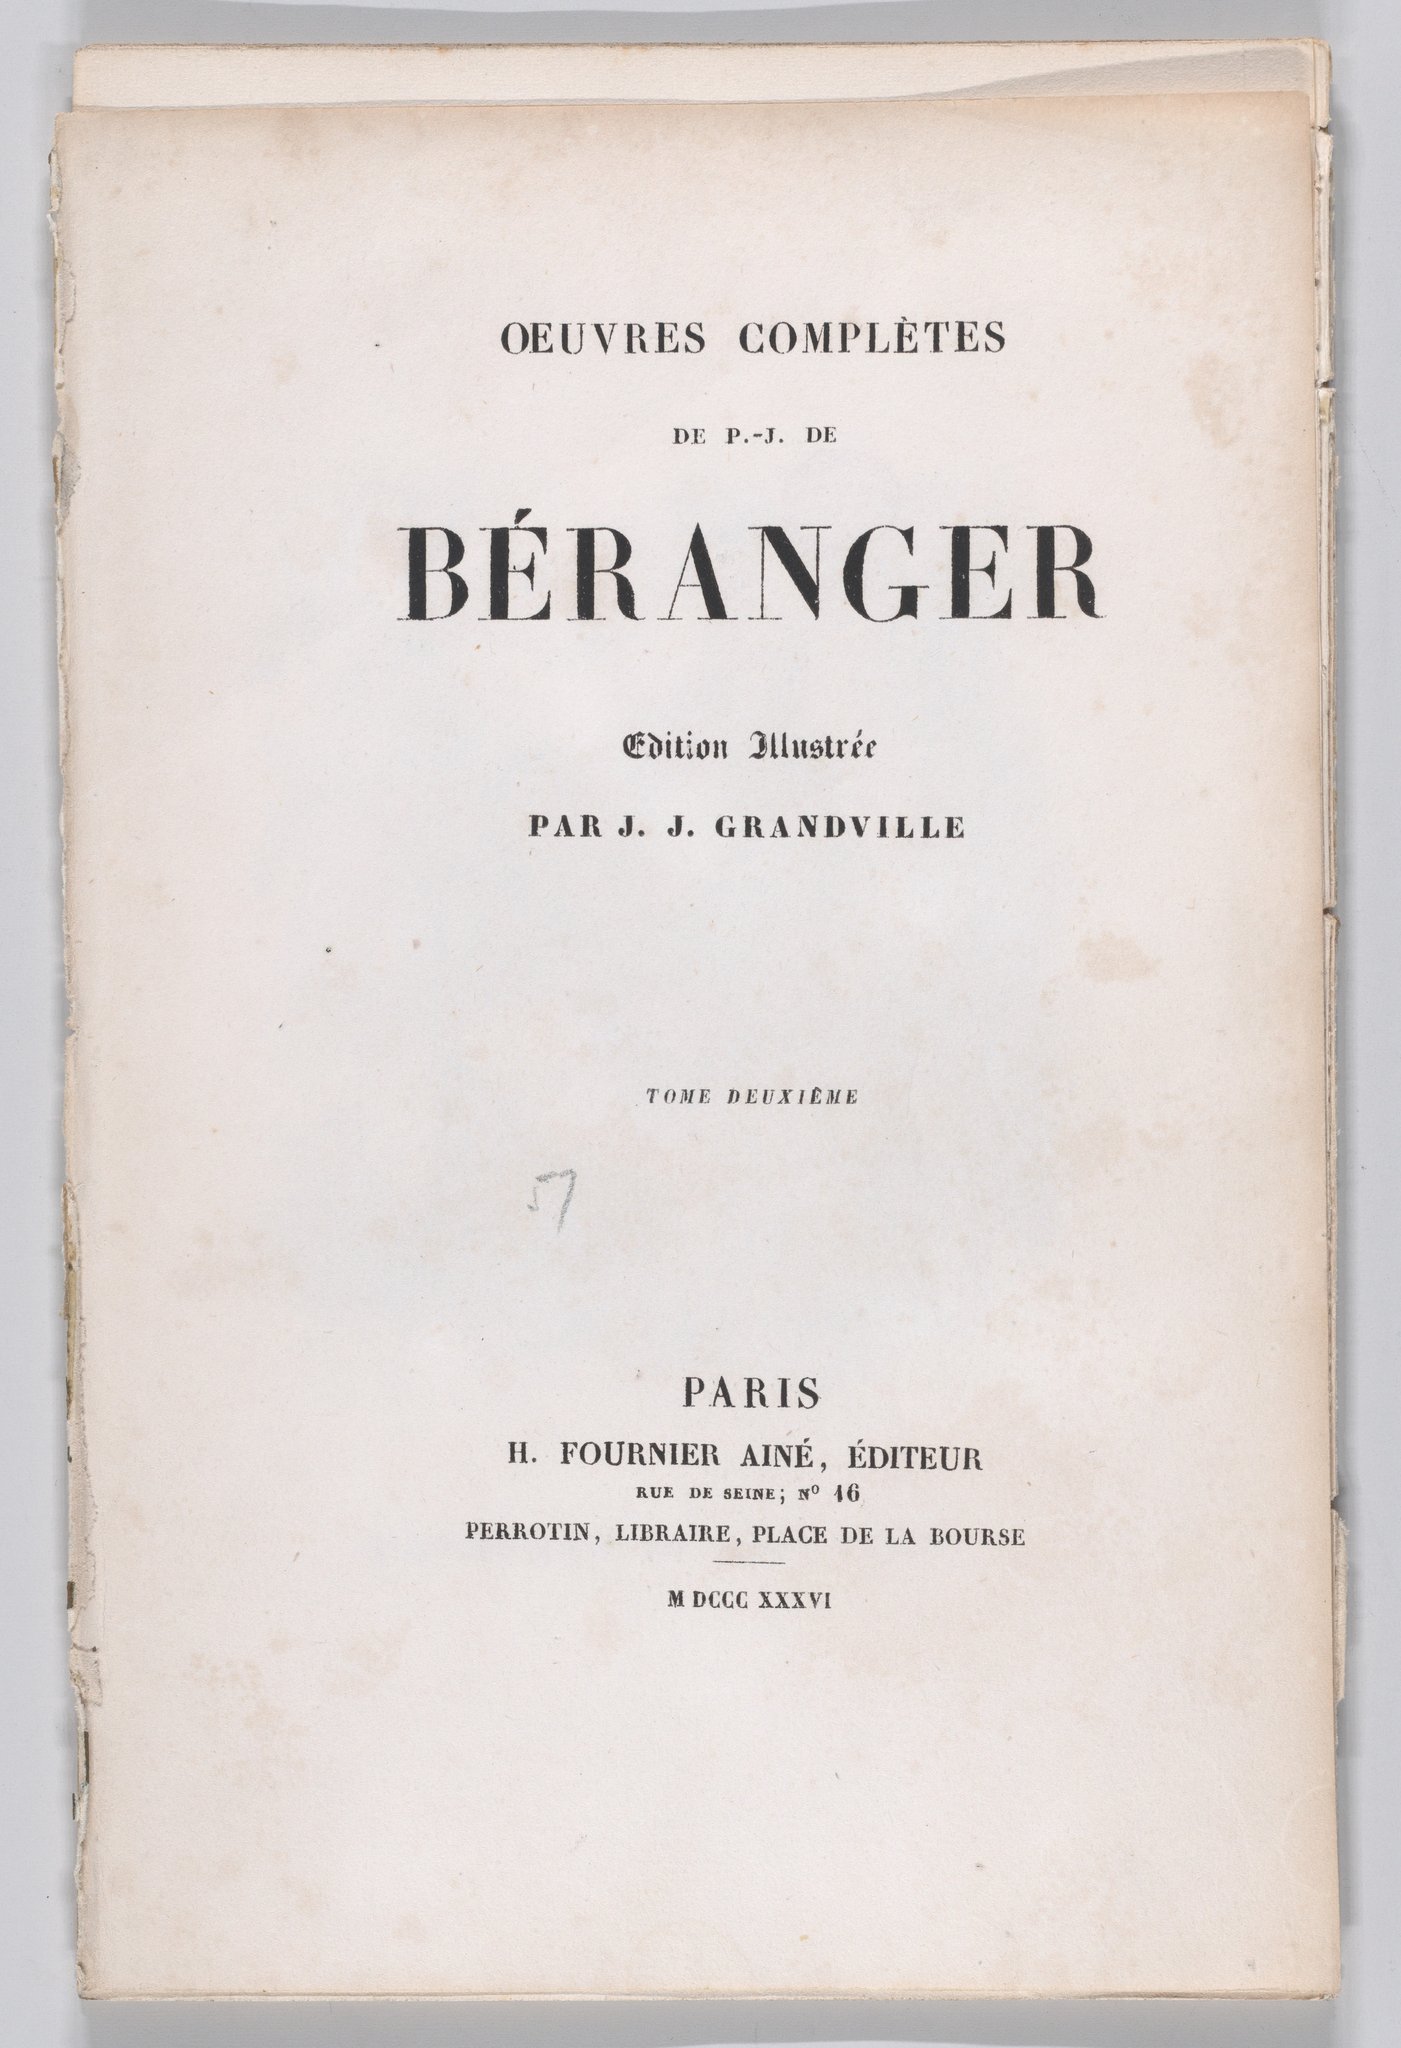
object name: print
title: The Complete Works of P.J. de Béranger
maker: anonymous, french, 19th century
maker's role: artist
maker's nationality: french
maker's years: 1800-1900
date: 1836